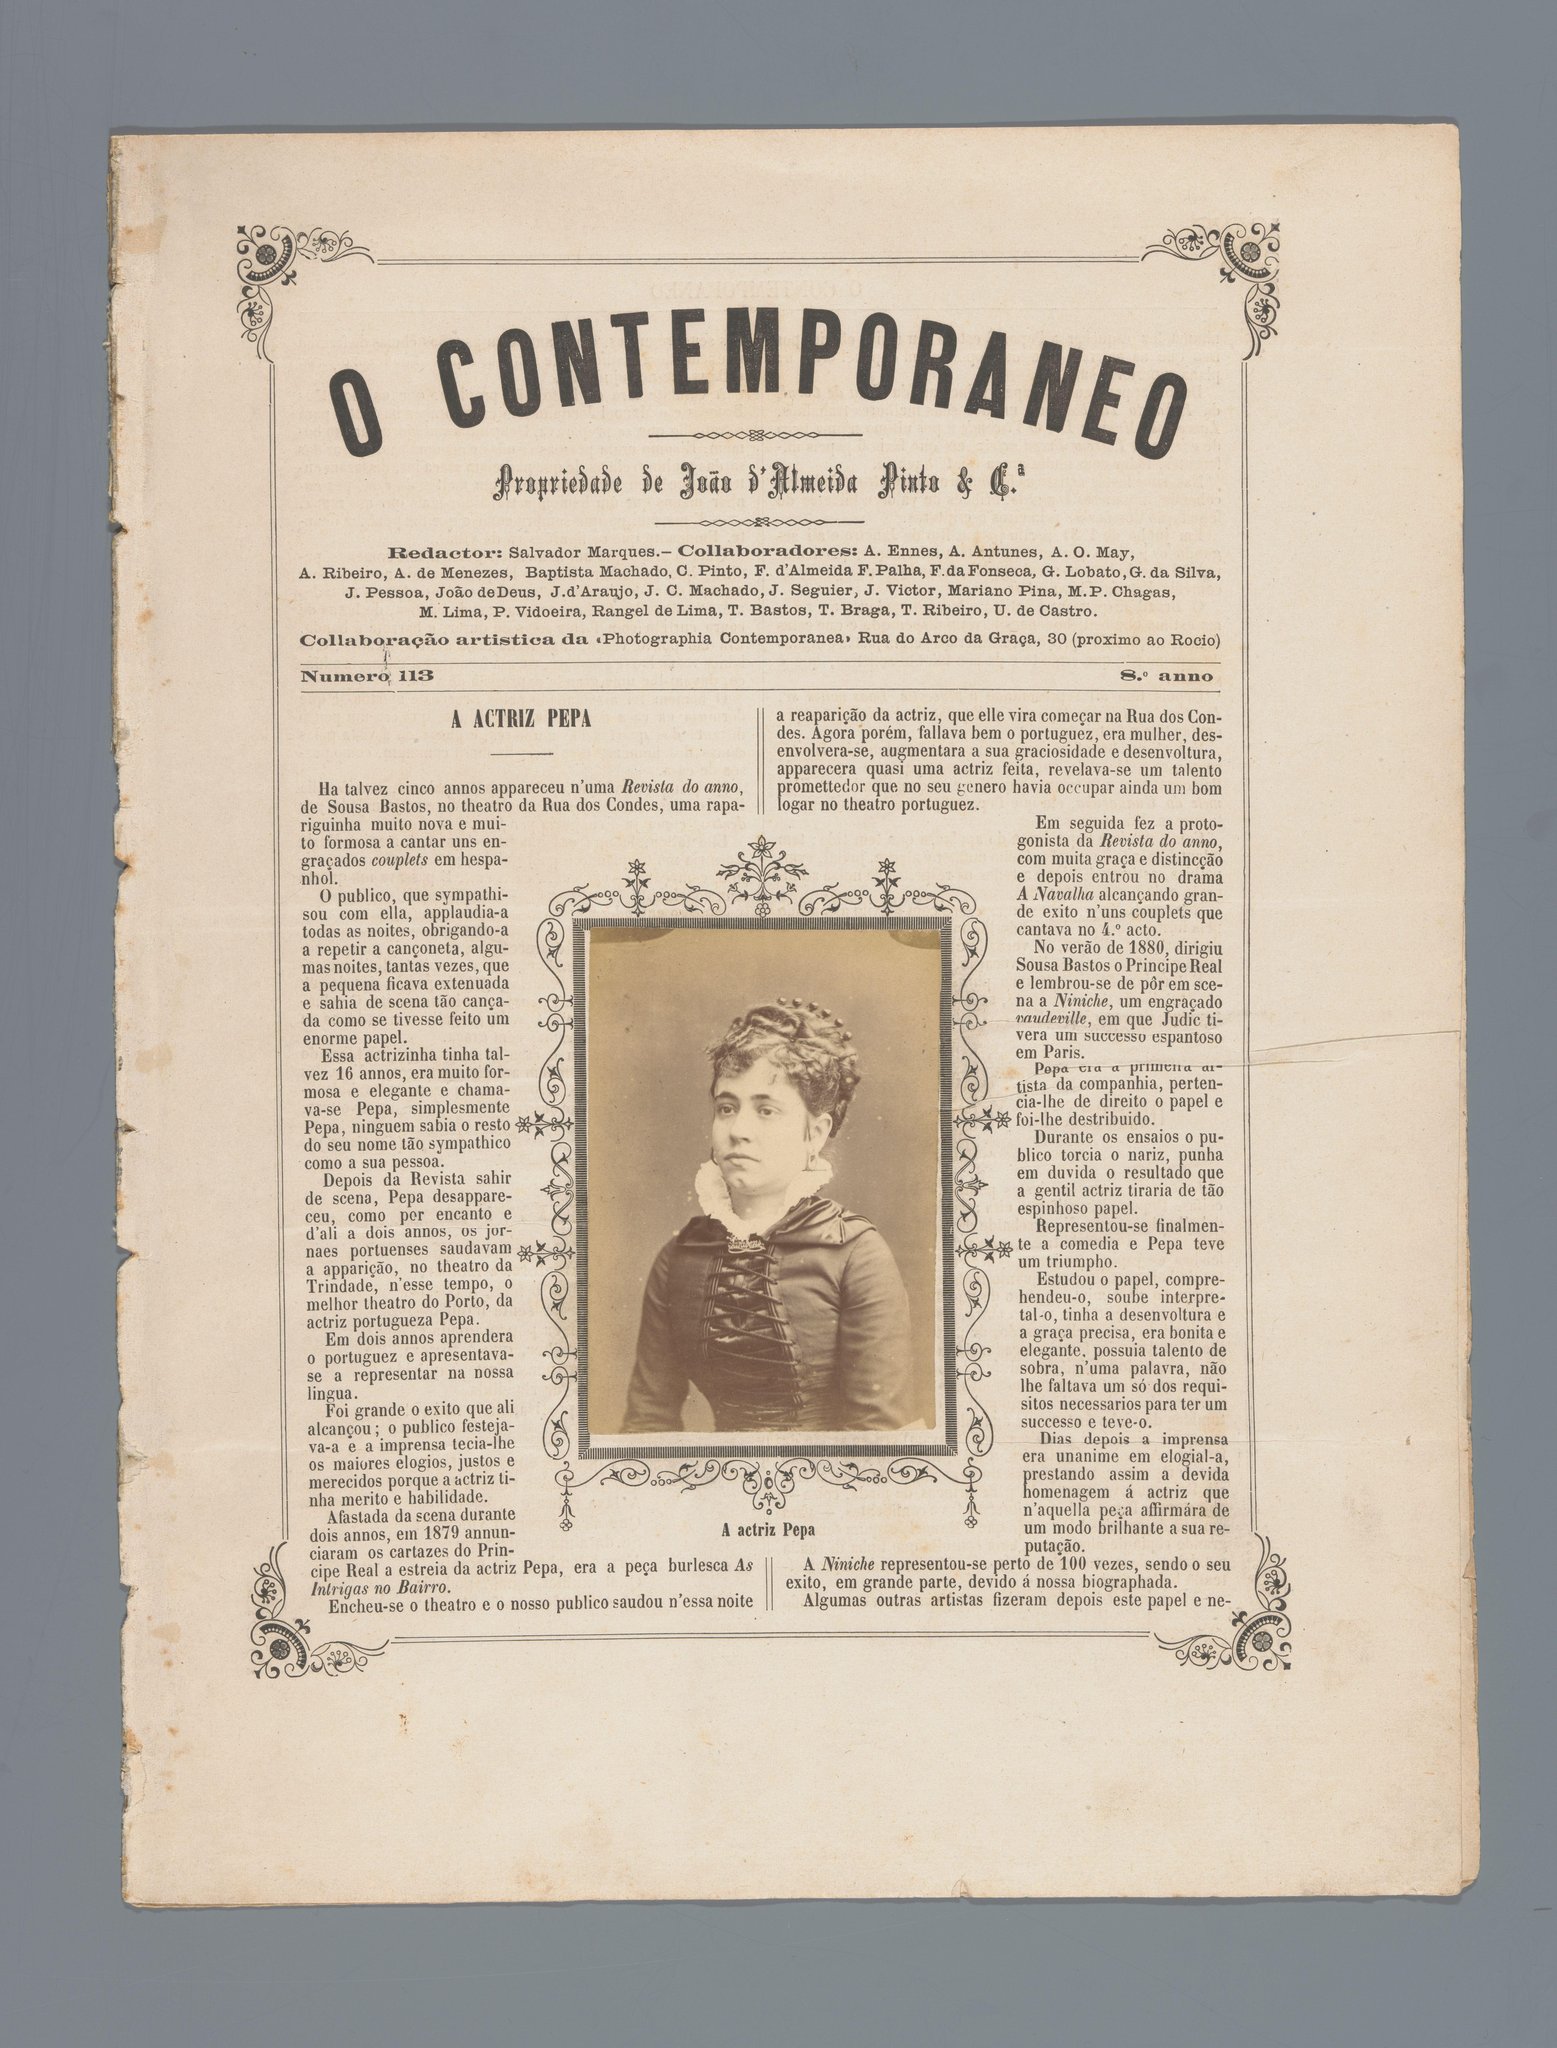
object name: photograph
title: O contemporaneo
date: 1877-1882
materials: paper, photographic support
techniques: albumen print, printing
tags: historical persons - bb - woman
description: Foto op voorpagina. Dit nummer zit vastgelijmd aan nummer 119 van O contemporaneo.